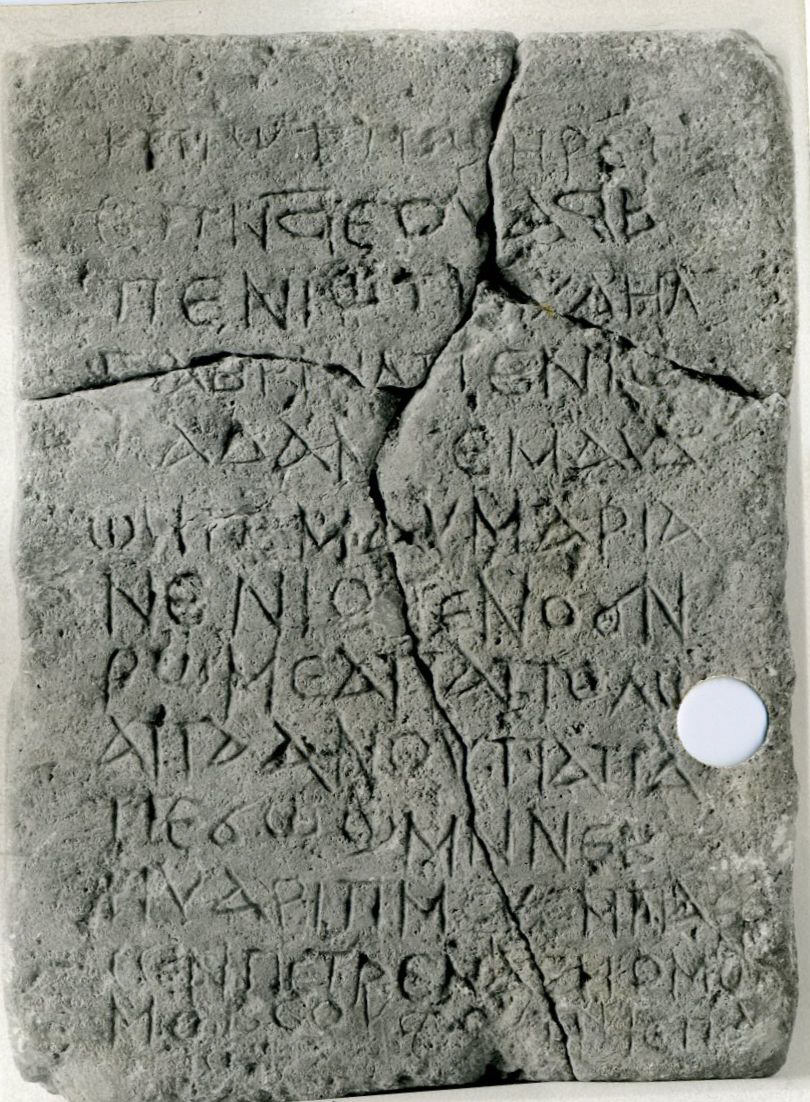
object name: stele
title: Inscribed stele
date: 601-900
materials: limestone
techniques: incising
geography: egypt